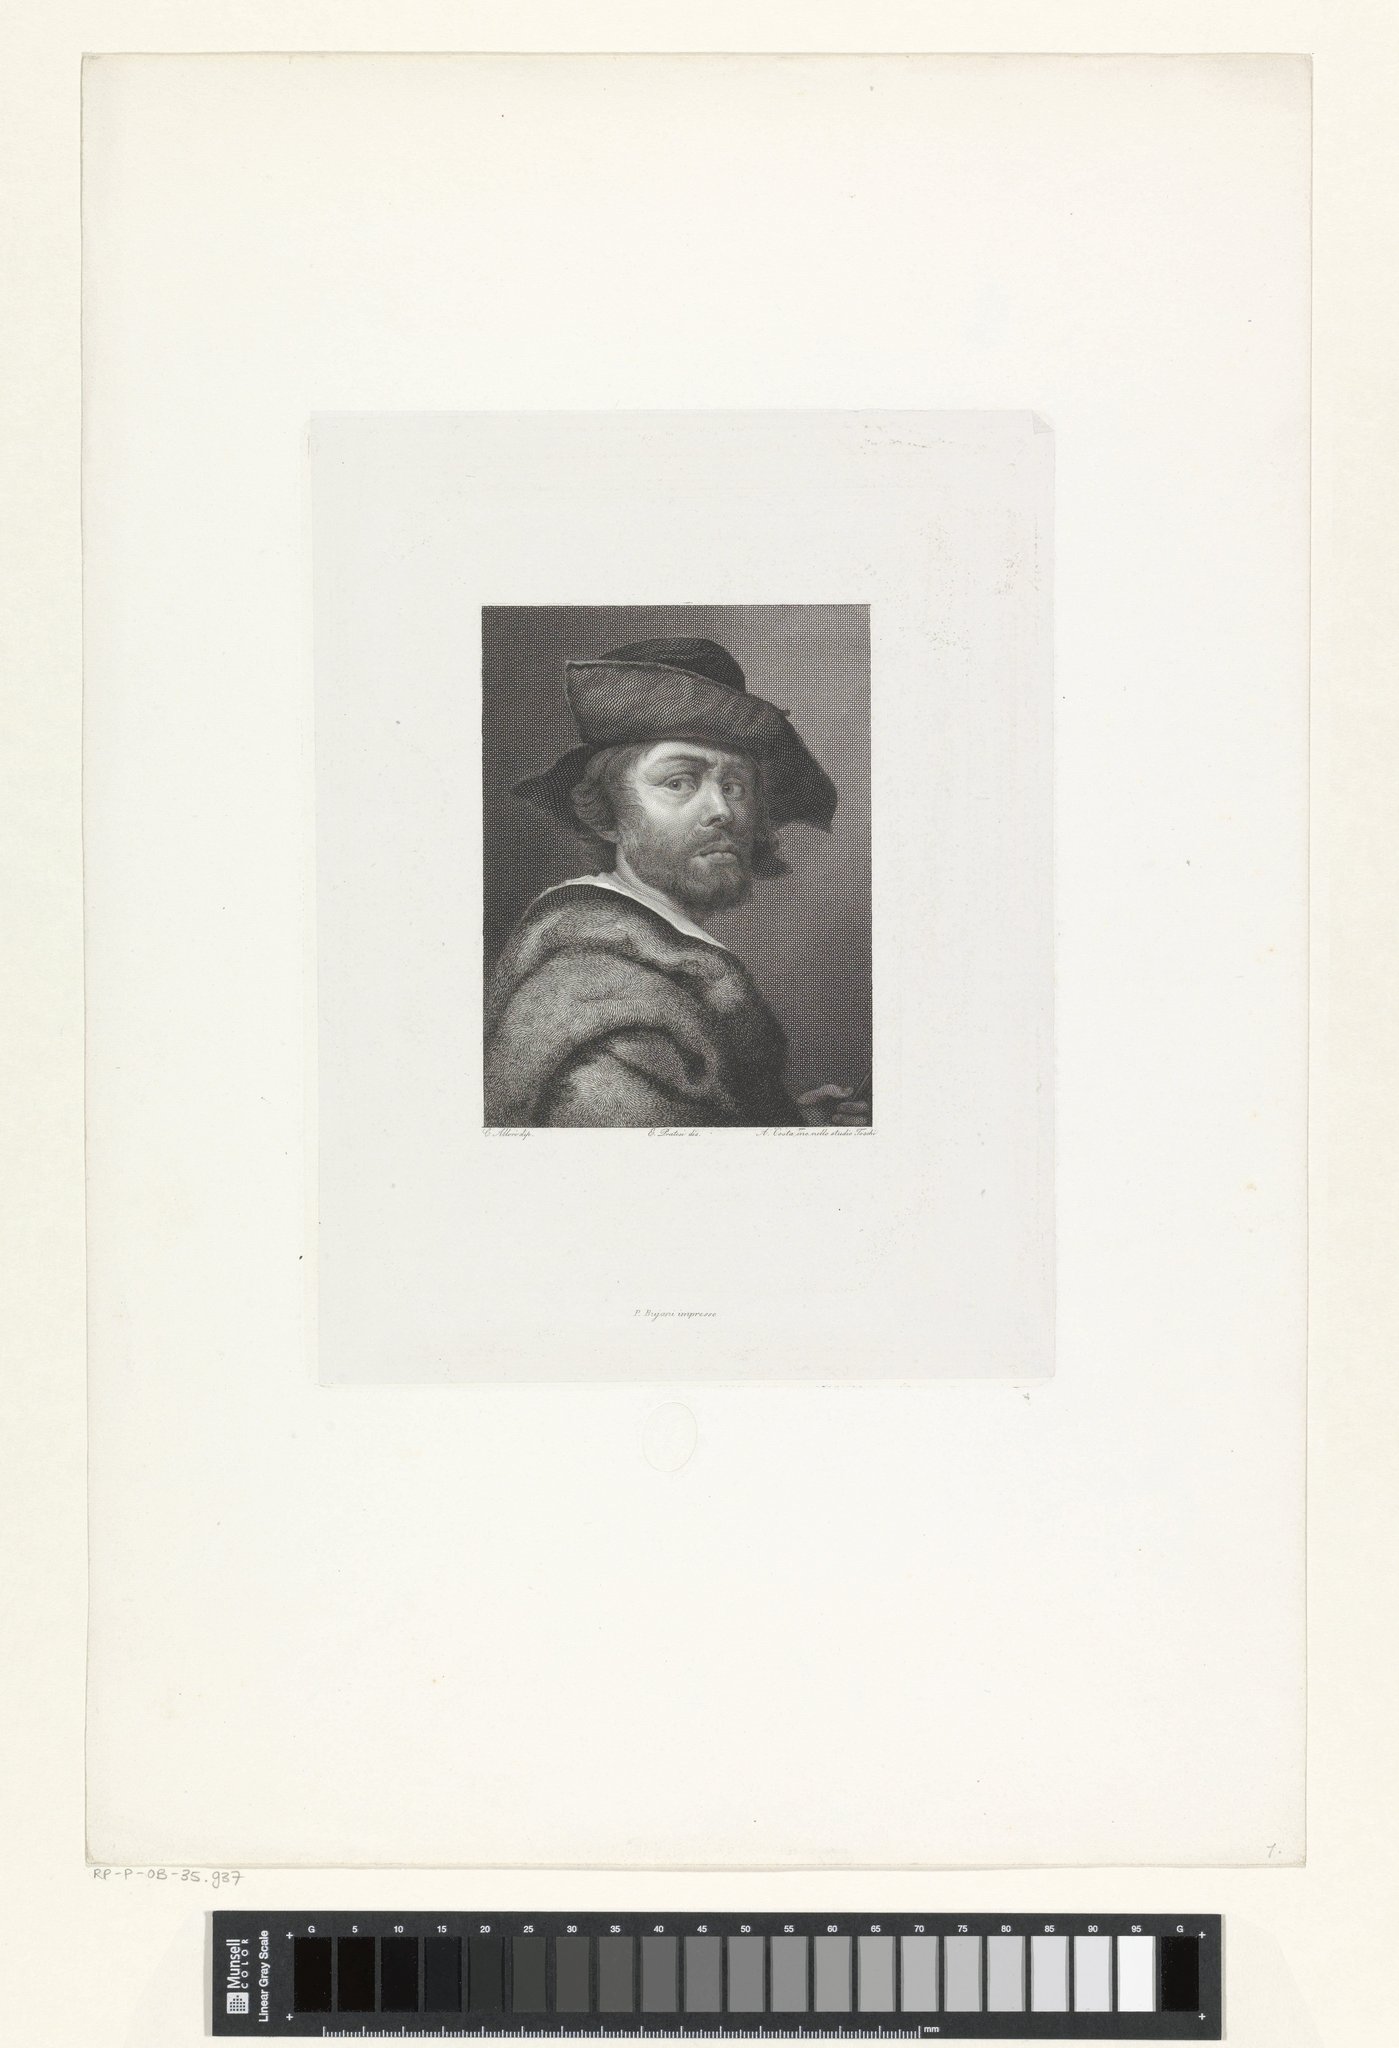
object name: print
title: Portret van schilder Cristofano Allori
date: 1814-1875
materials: paper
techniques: engraving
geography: italy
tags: draughtsman, cristofano allori, historical persons, portrait, self-portrait of artist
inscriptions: collector's mark: ‘Ovaal met fleur de lys en tekst.’, collector's mark: Lugt 2228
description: Naar zelfportret van Cristofano Allori in de Galleria degli Uffizi te Florence.